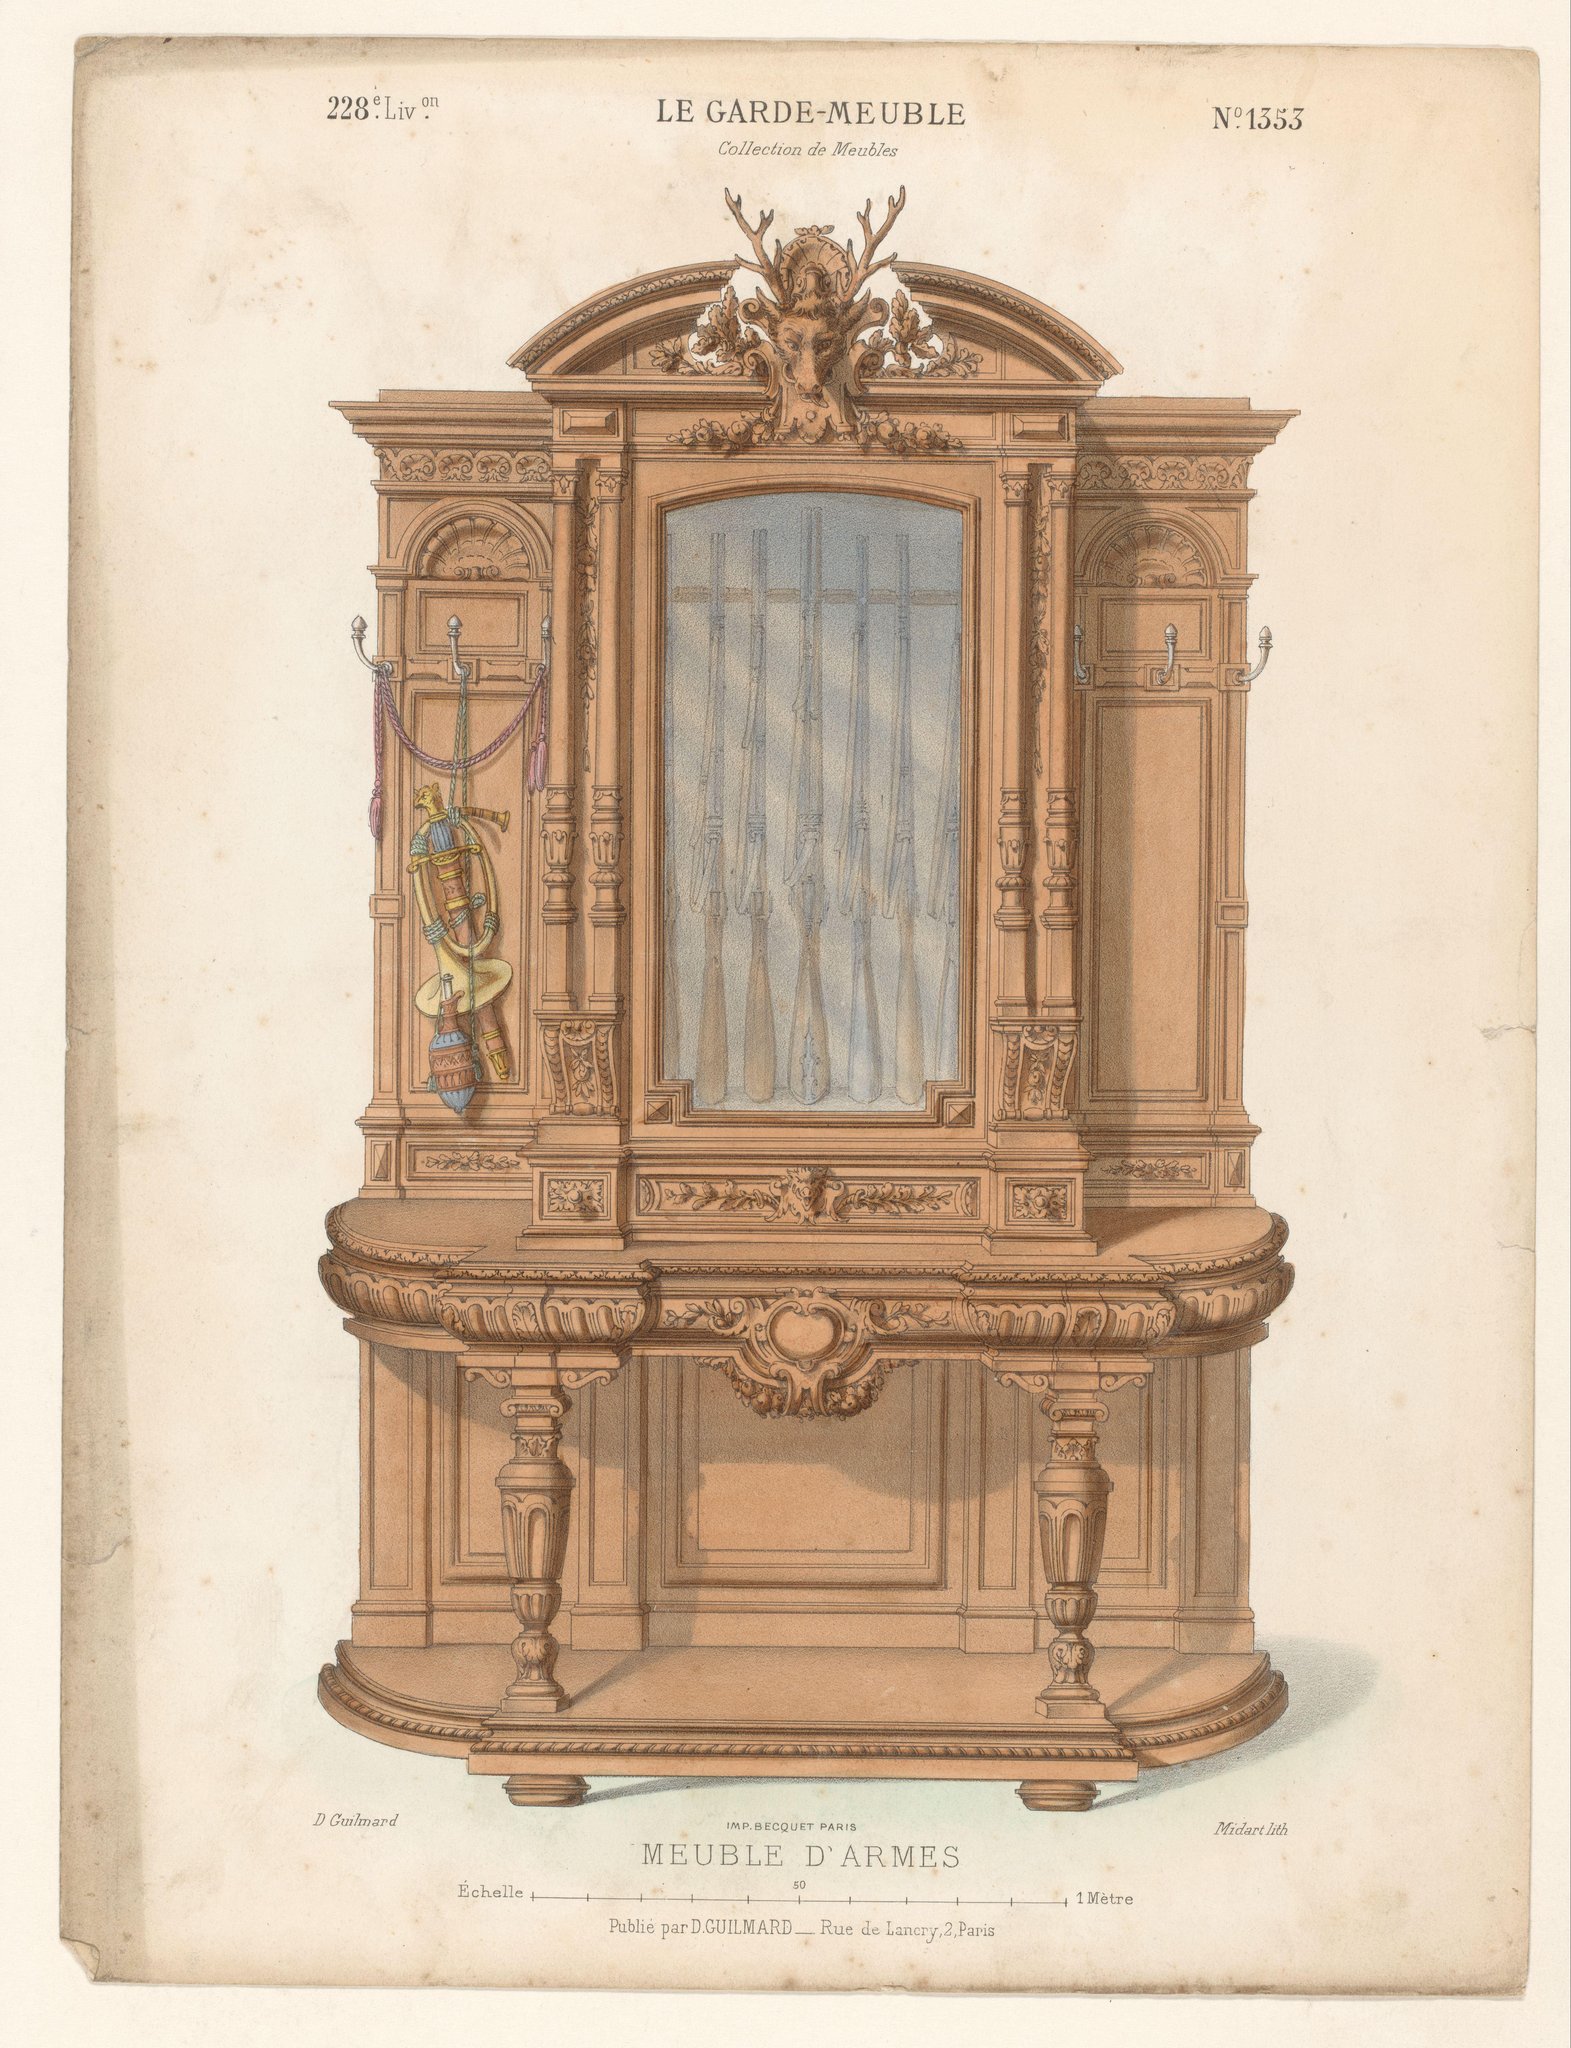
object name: print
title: Le garde-meuble / Collection de Meubles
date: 1839-1885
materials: paper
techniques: hand coloring, lithograph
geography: paris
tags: furniture for storage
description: Ieder Livraison in de serie Le Garde-Meuble bevat negen platen: drie 'sièges' (zitmeubels), drie 'meubles' (diverse meubels zoals tafels en kasten) en drie 'tentures' (gordijnen en draperieën).